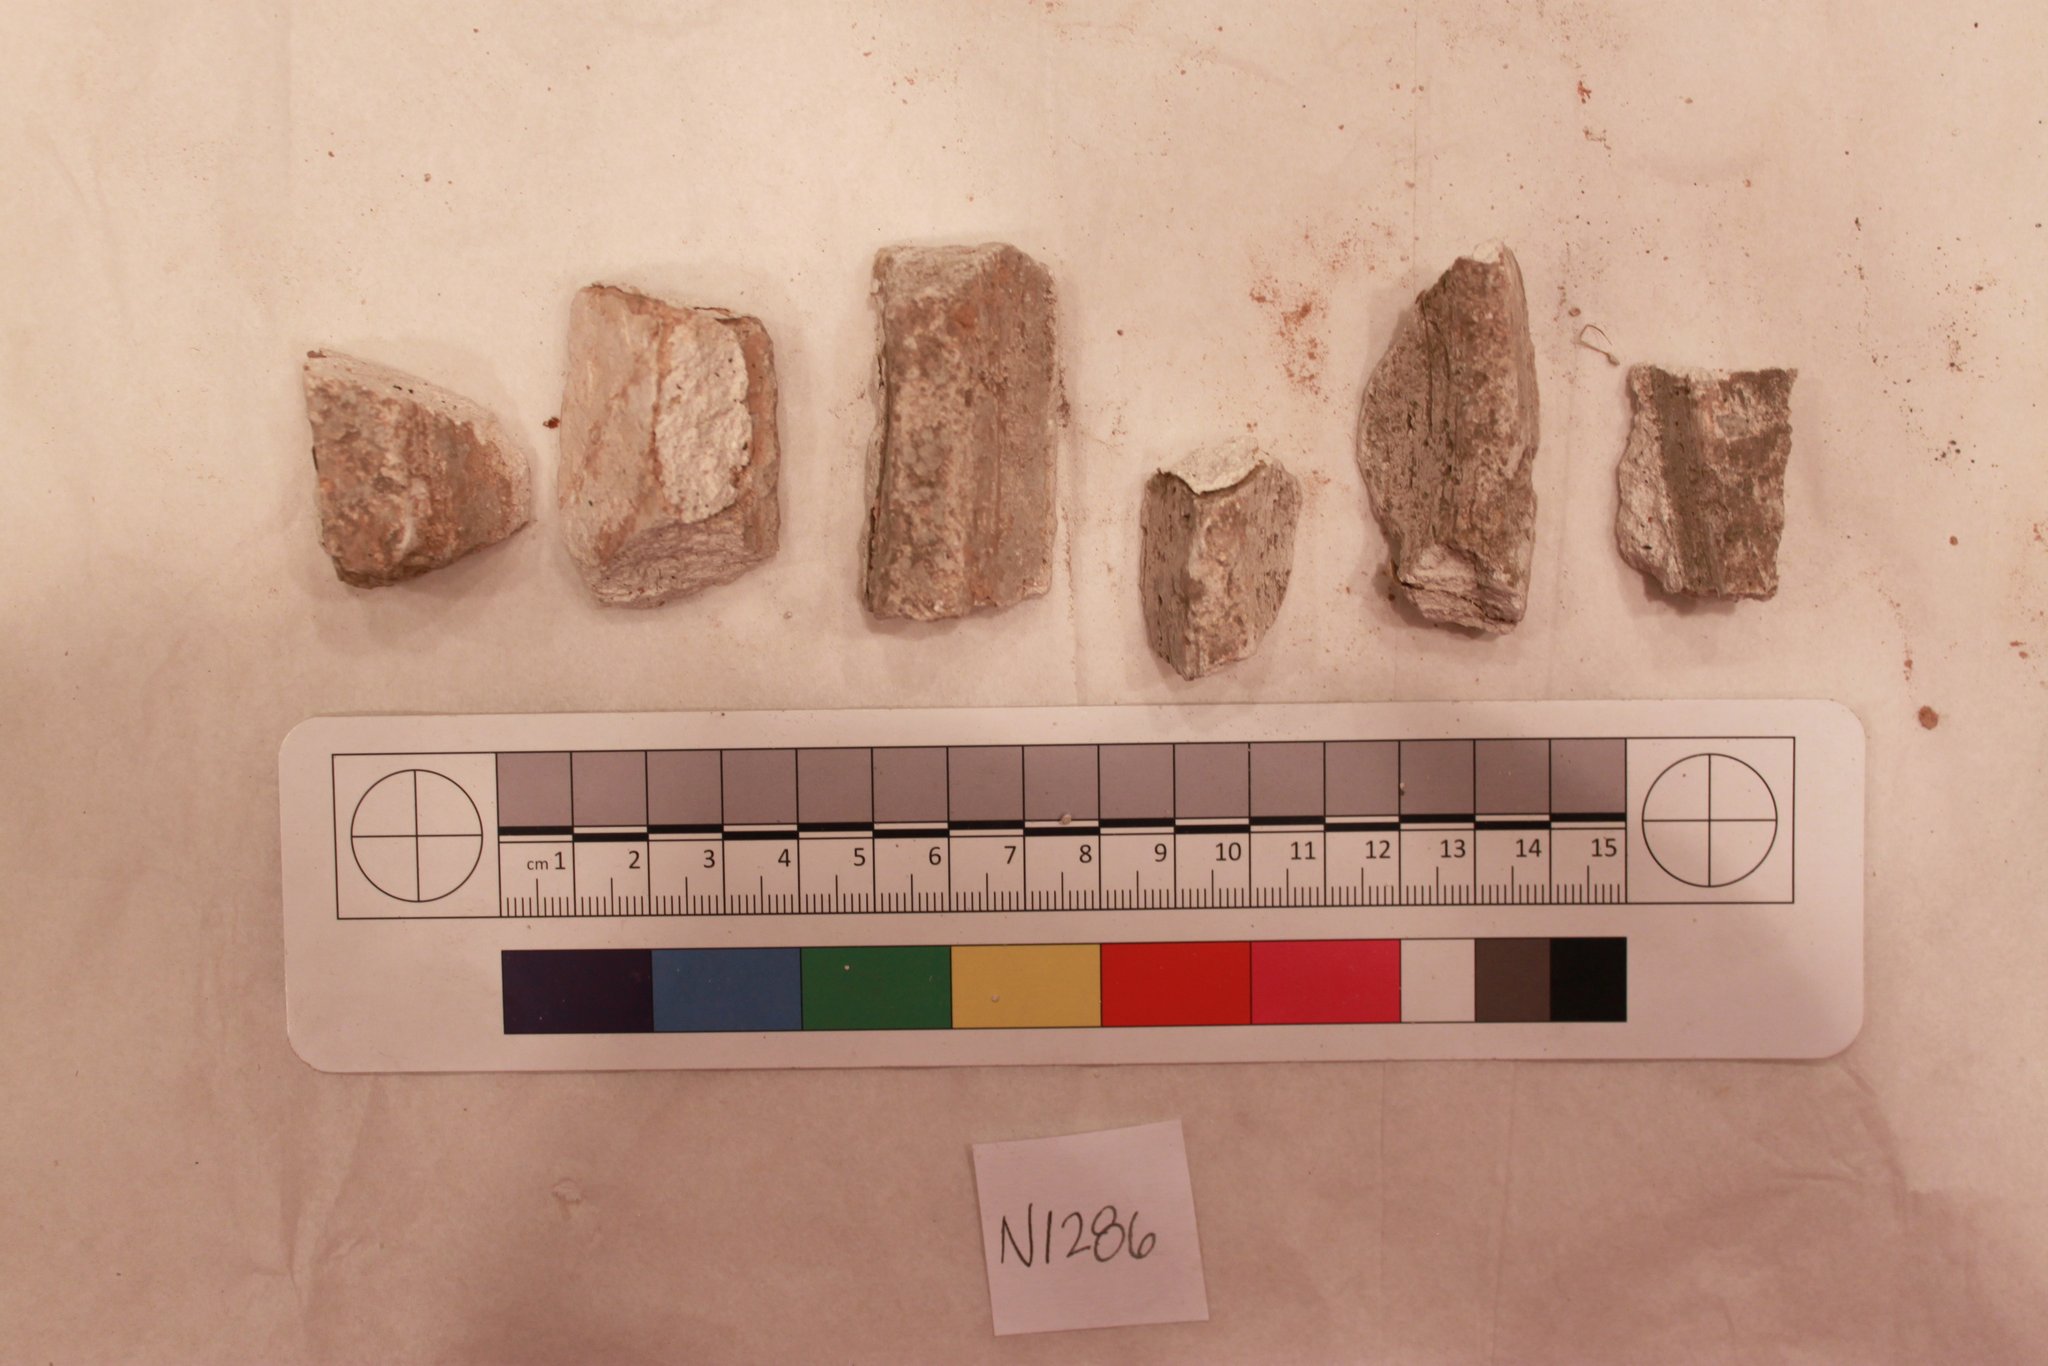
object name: fragment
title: Stucco Fragment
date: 701-1200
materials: plaster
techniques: carving, painting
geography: iran